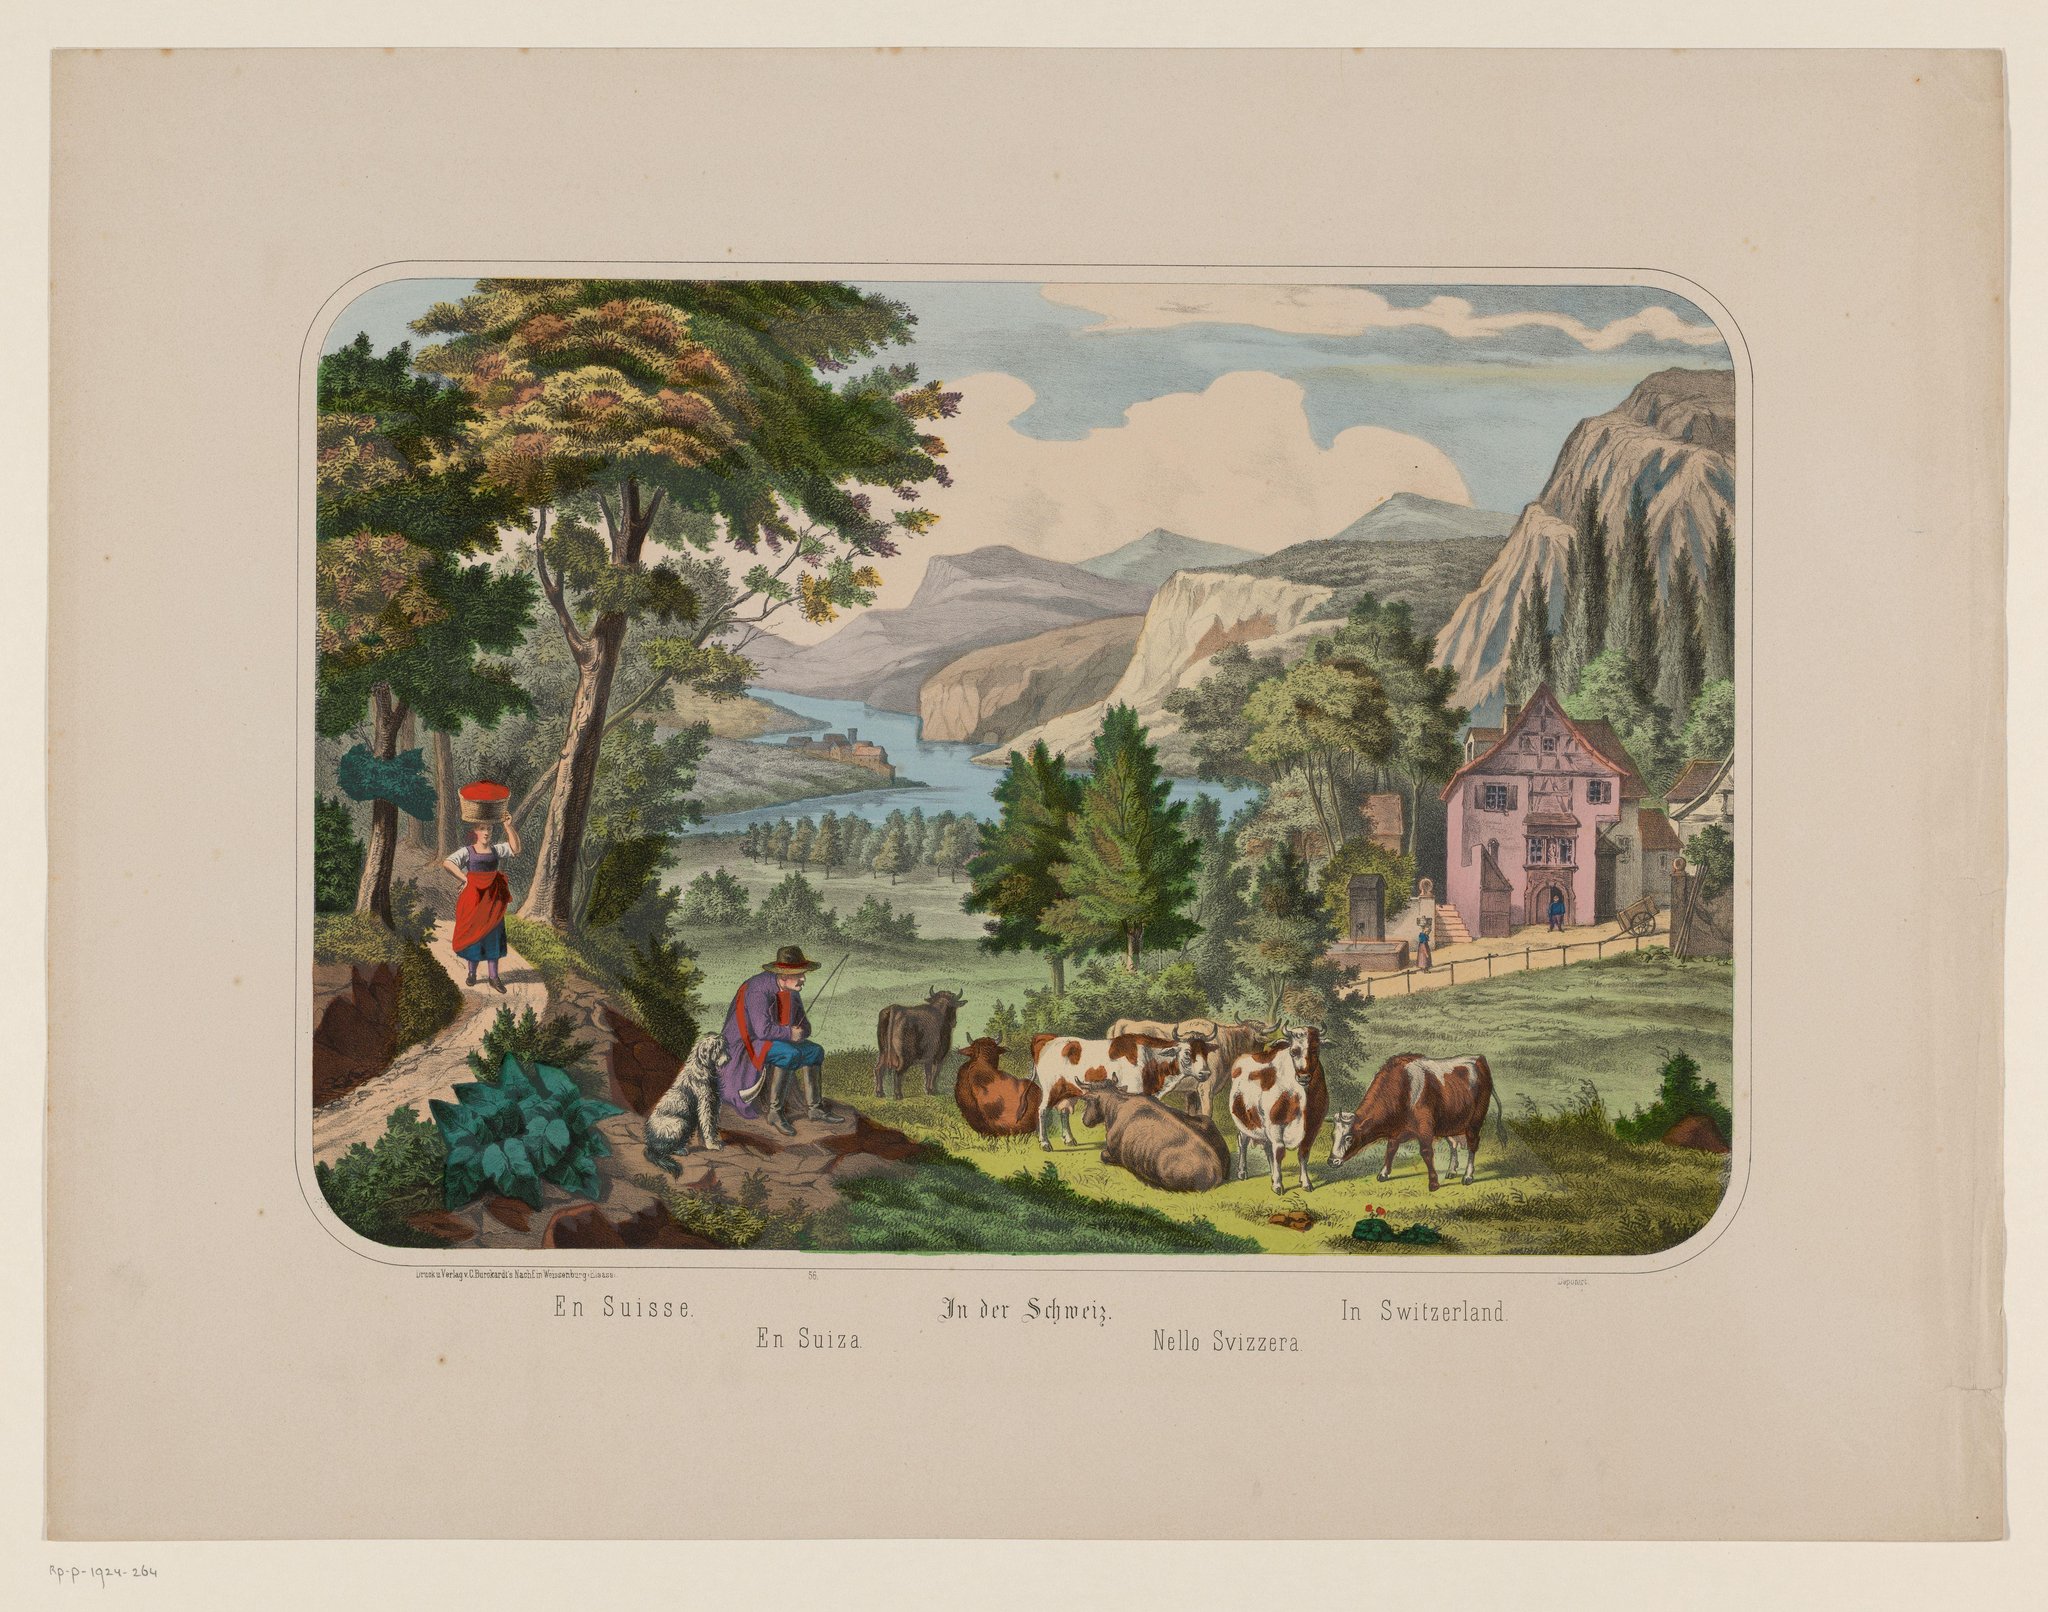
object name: print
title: En Suisse / En Suiza / In der Schweiz / Nello Svizzera / In Switzerland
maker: Anonymous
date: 1889-1906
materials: paper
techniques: lithograph, hand coloring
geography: weissenburg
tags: herding, herdsman, herdswoman, shepherd, shepherdess, cowherd, etc., lake - hh - ideal landscapes, mountains, switzerland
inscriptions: collector's mark: Lugt 2233